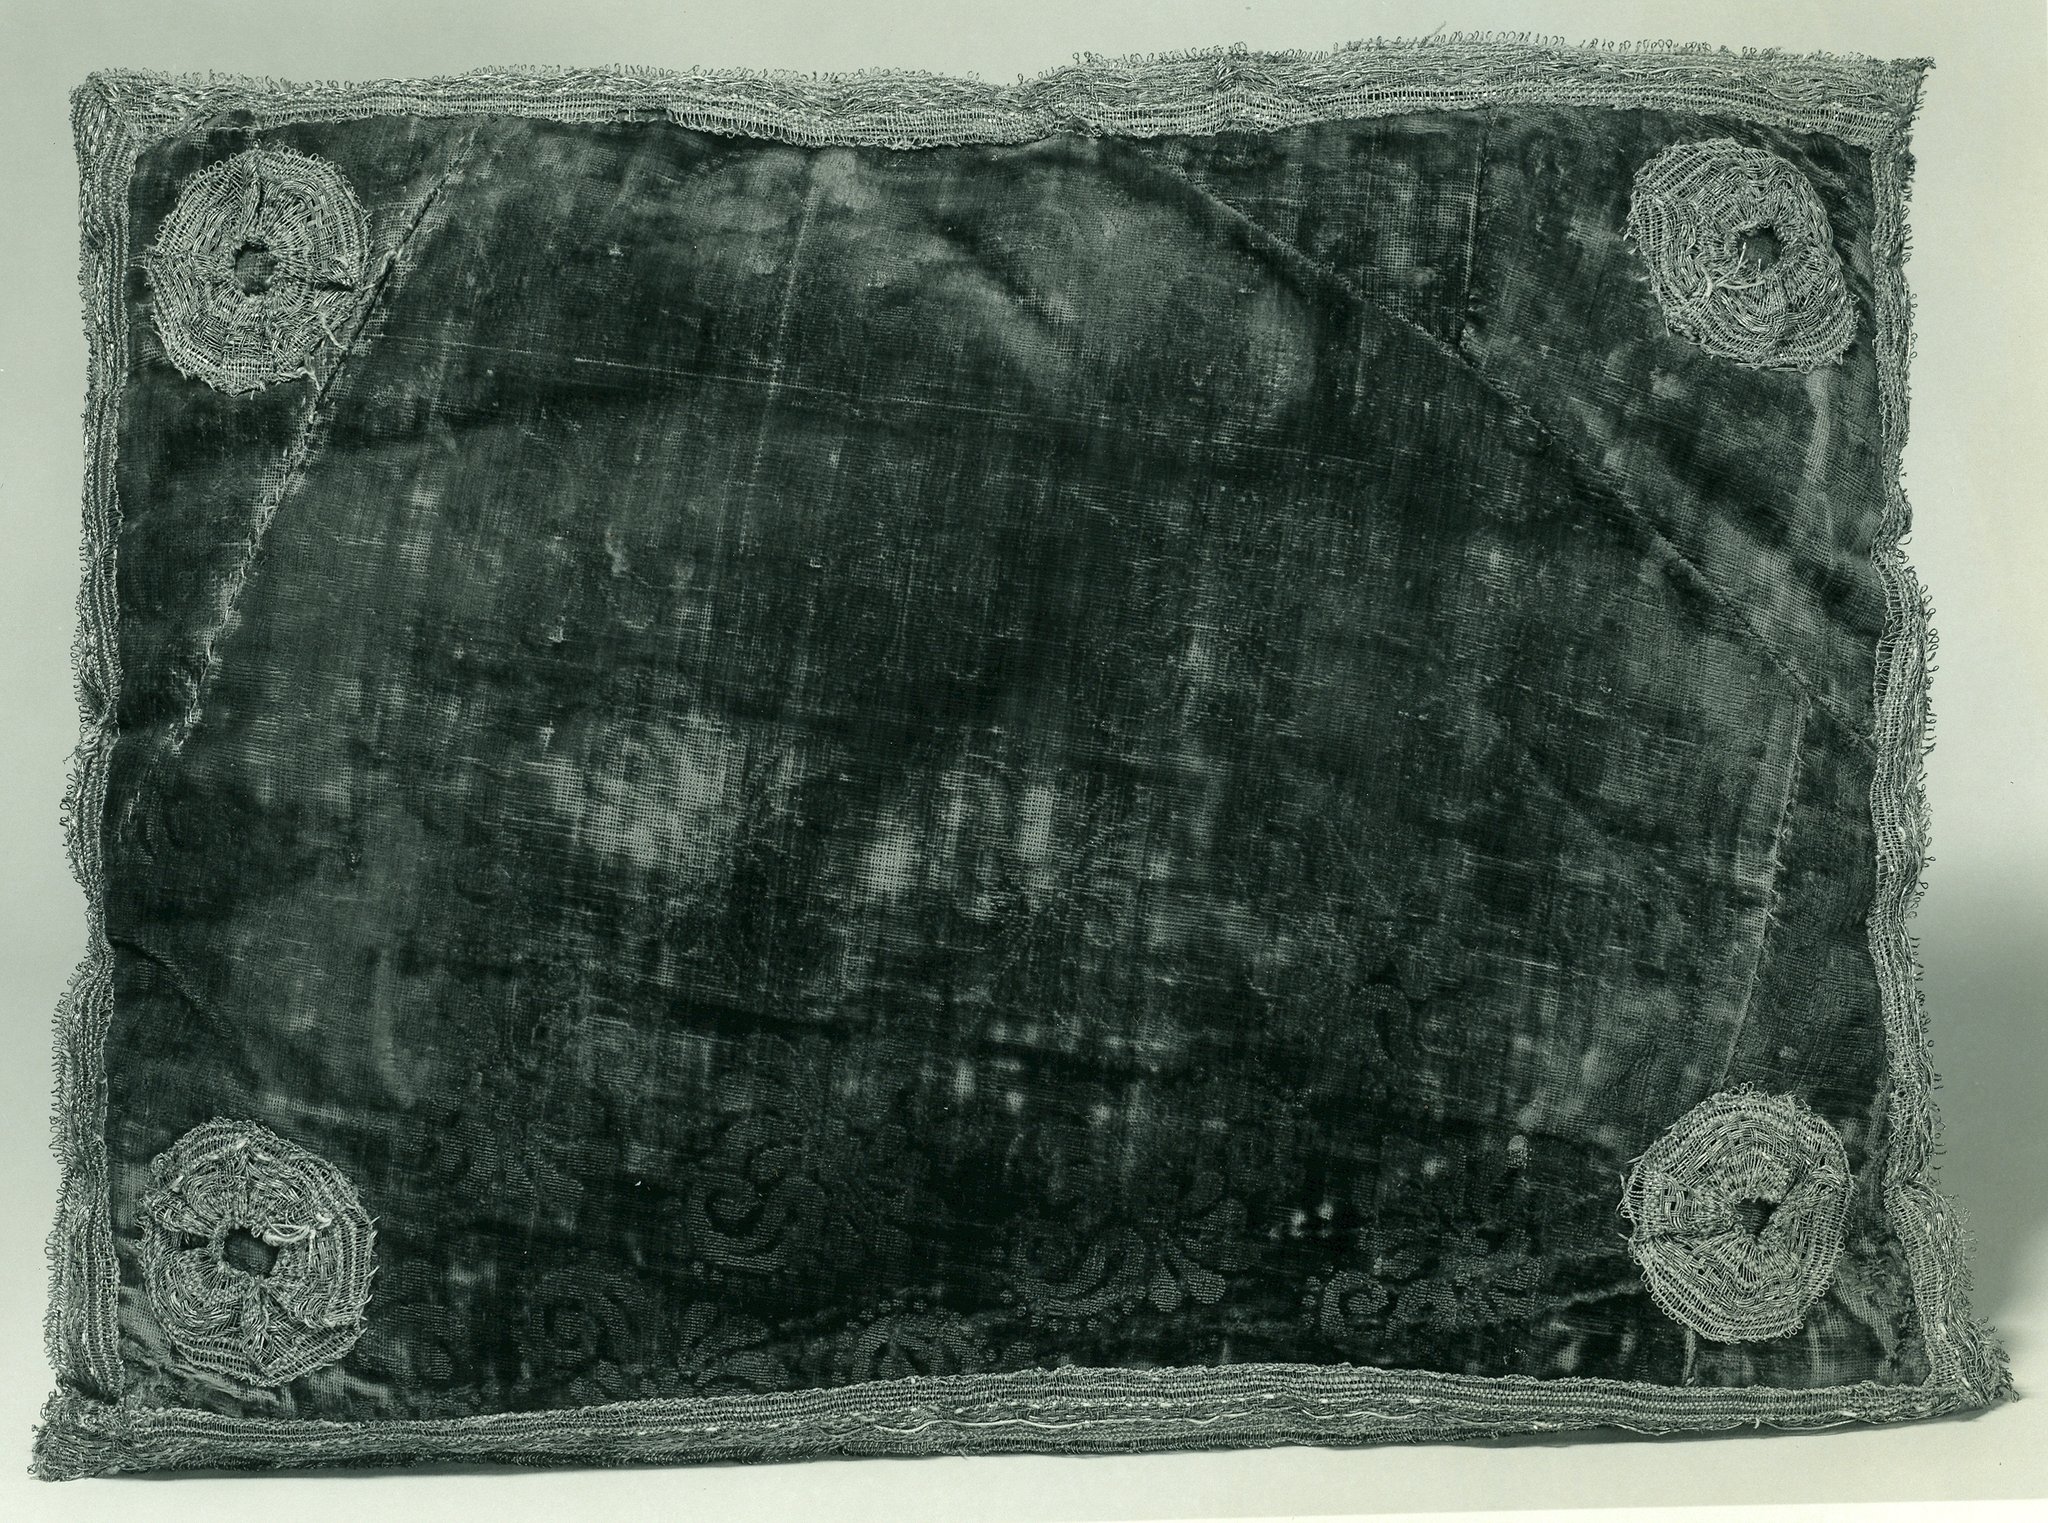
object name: cushion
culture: italian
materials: linen, metal, silk